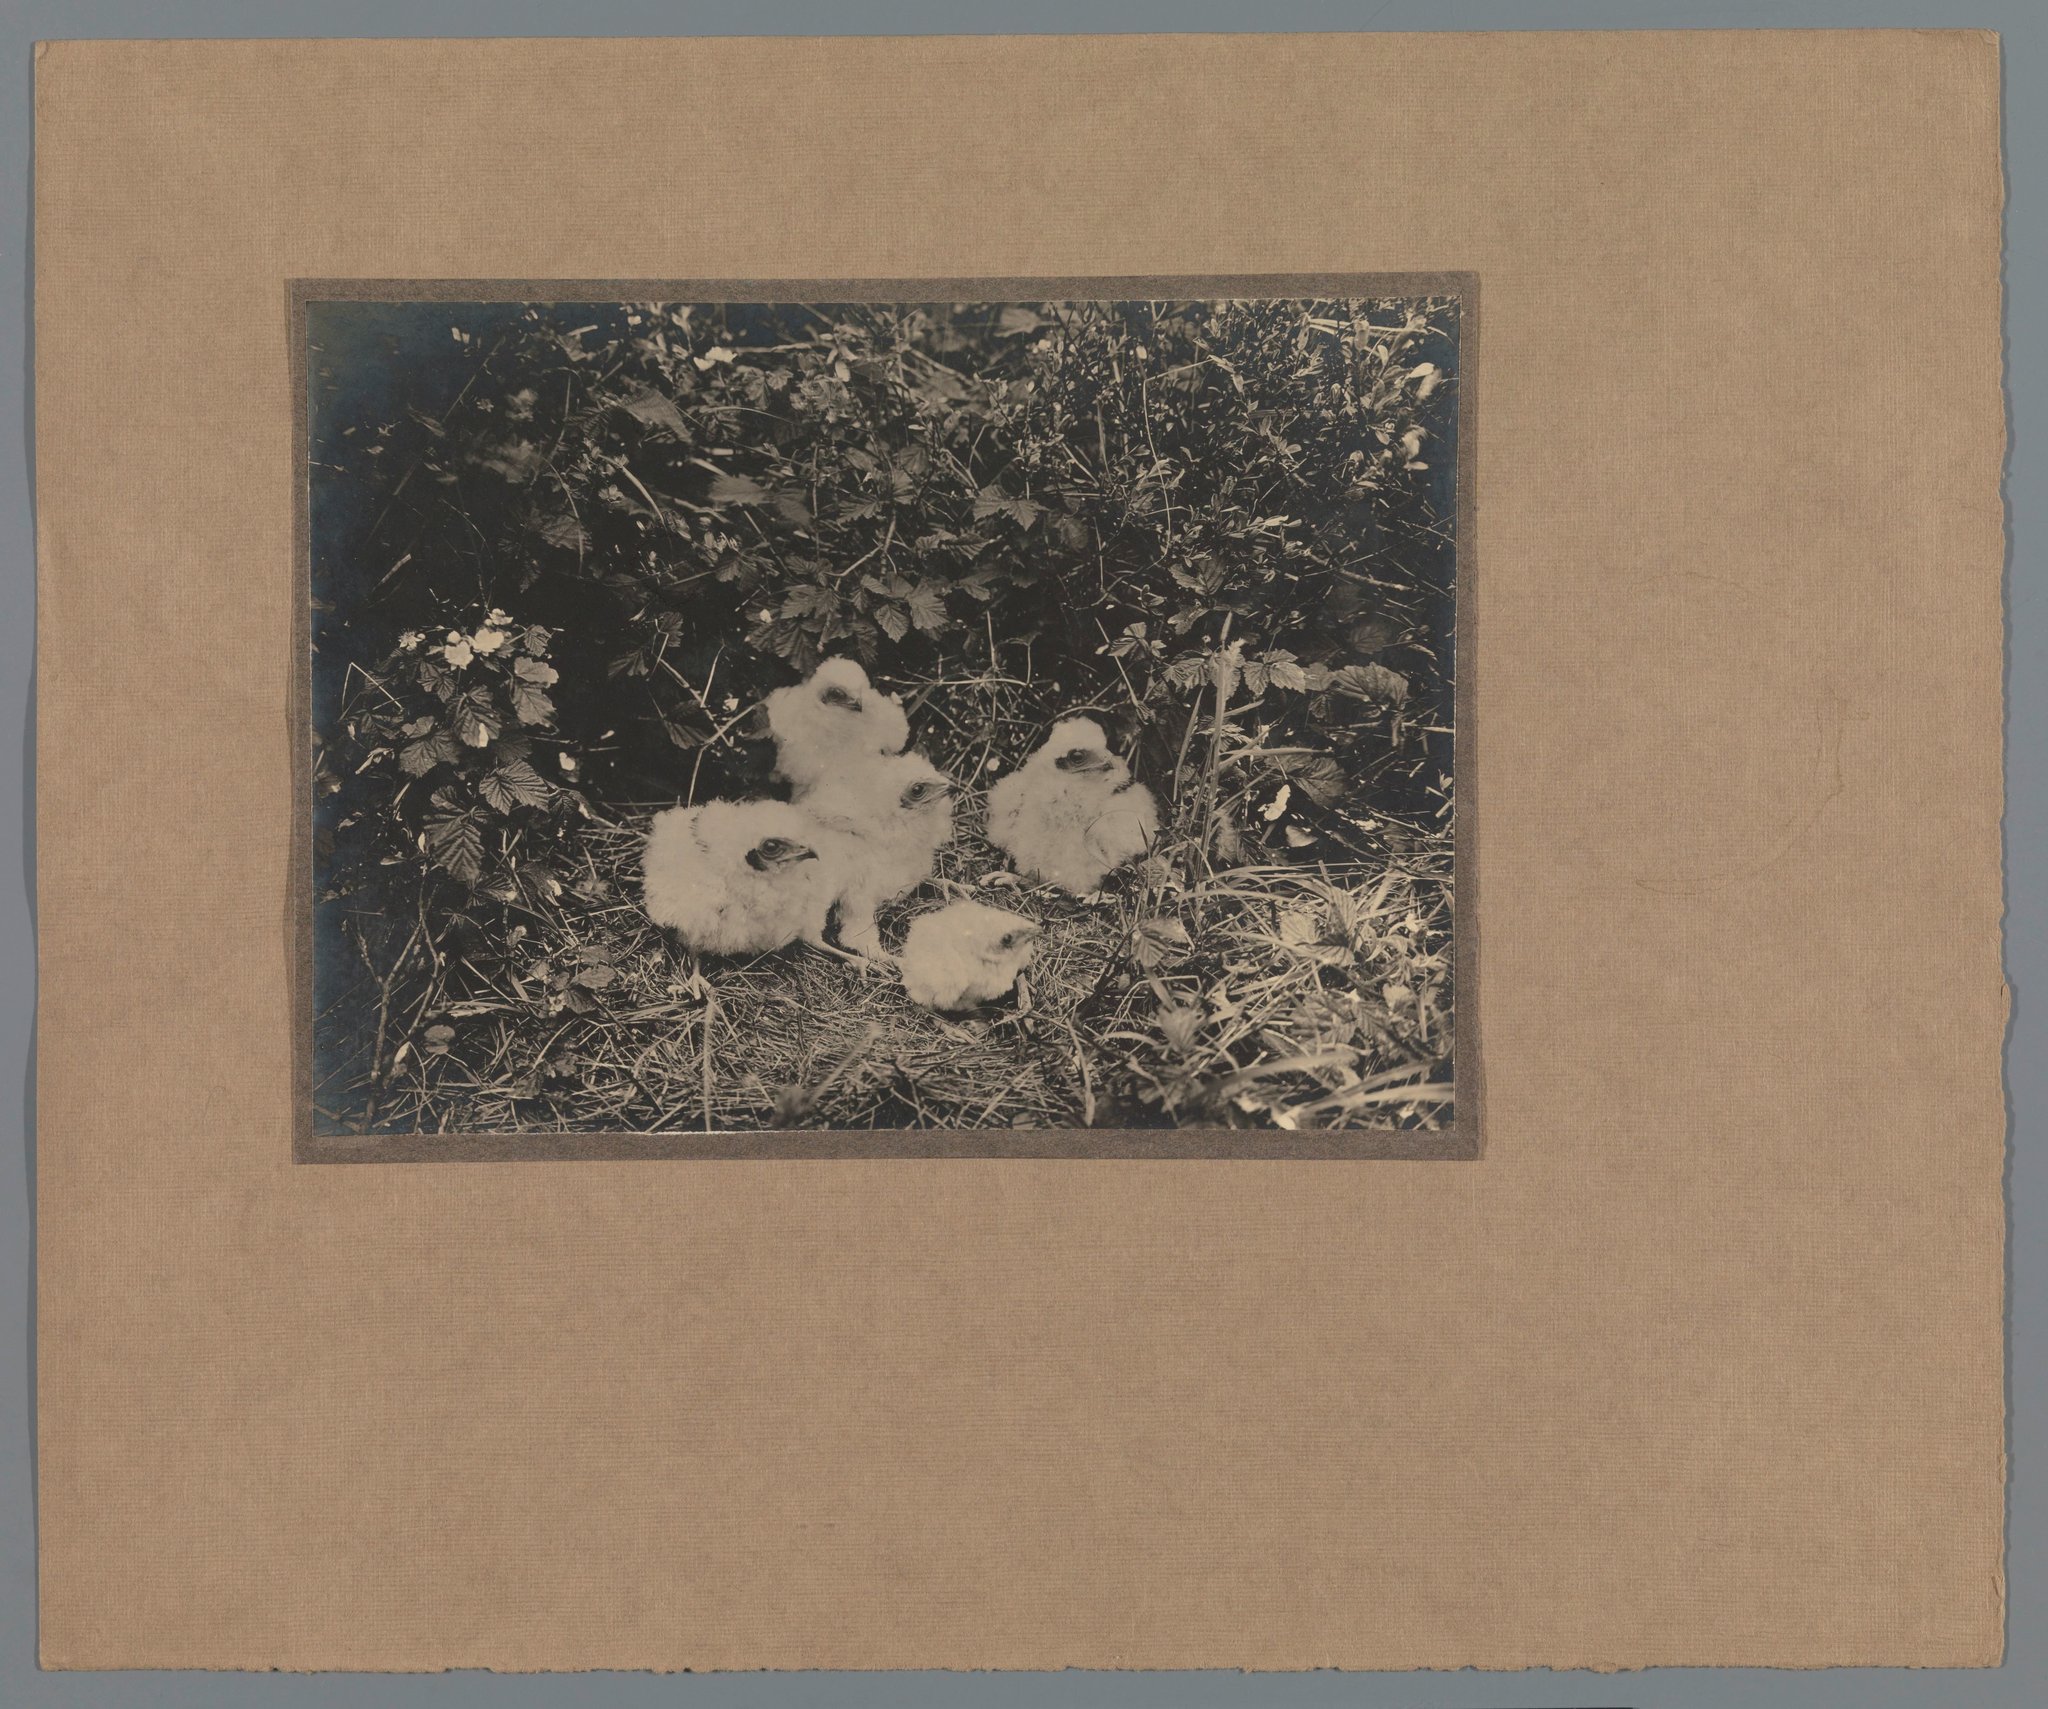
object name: photograph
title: Jonge grauwe kiekendieven in een nest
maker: richard tepe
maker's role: fotograaf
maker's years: 1864-1952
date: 1900-1952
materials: paper, cardboard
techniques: gelatin silver print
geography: netherlands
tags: predatory birds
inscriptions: signature: ‘R. Tepe Apeldoorn’, inscription: ‘Horst en Jongen van/ den Grauwen Kuikendief’